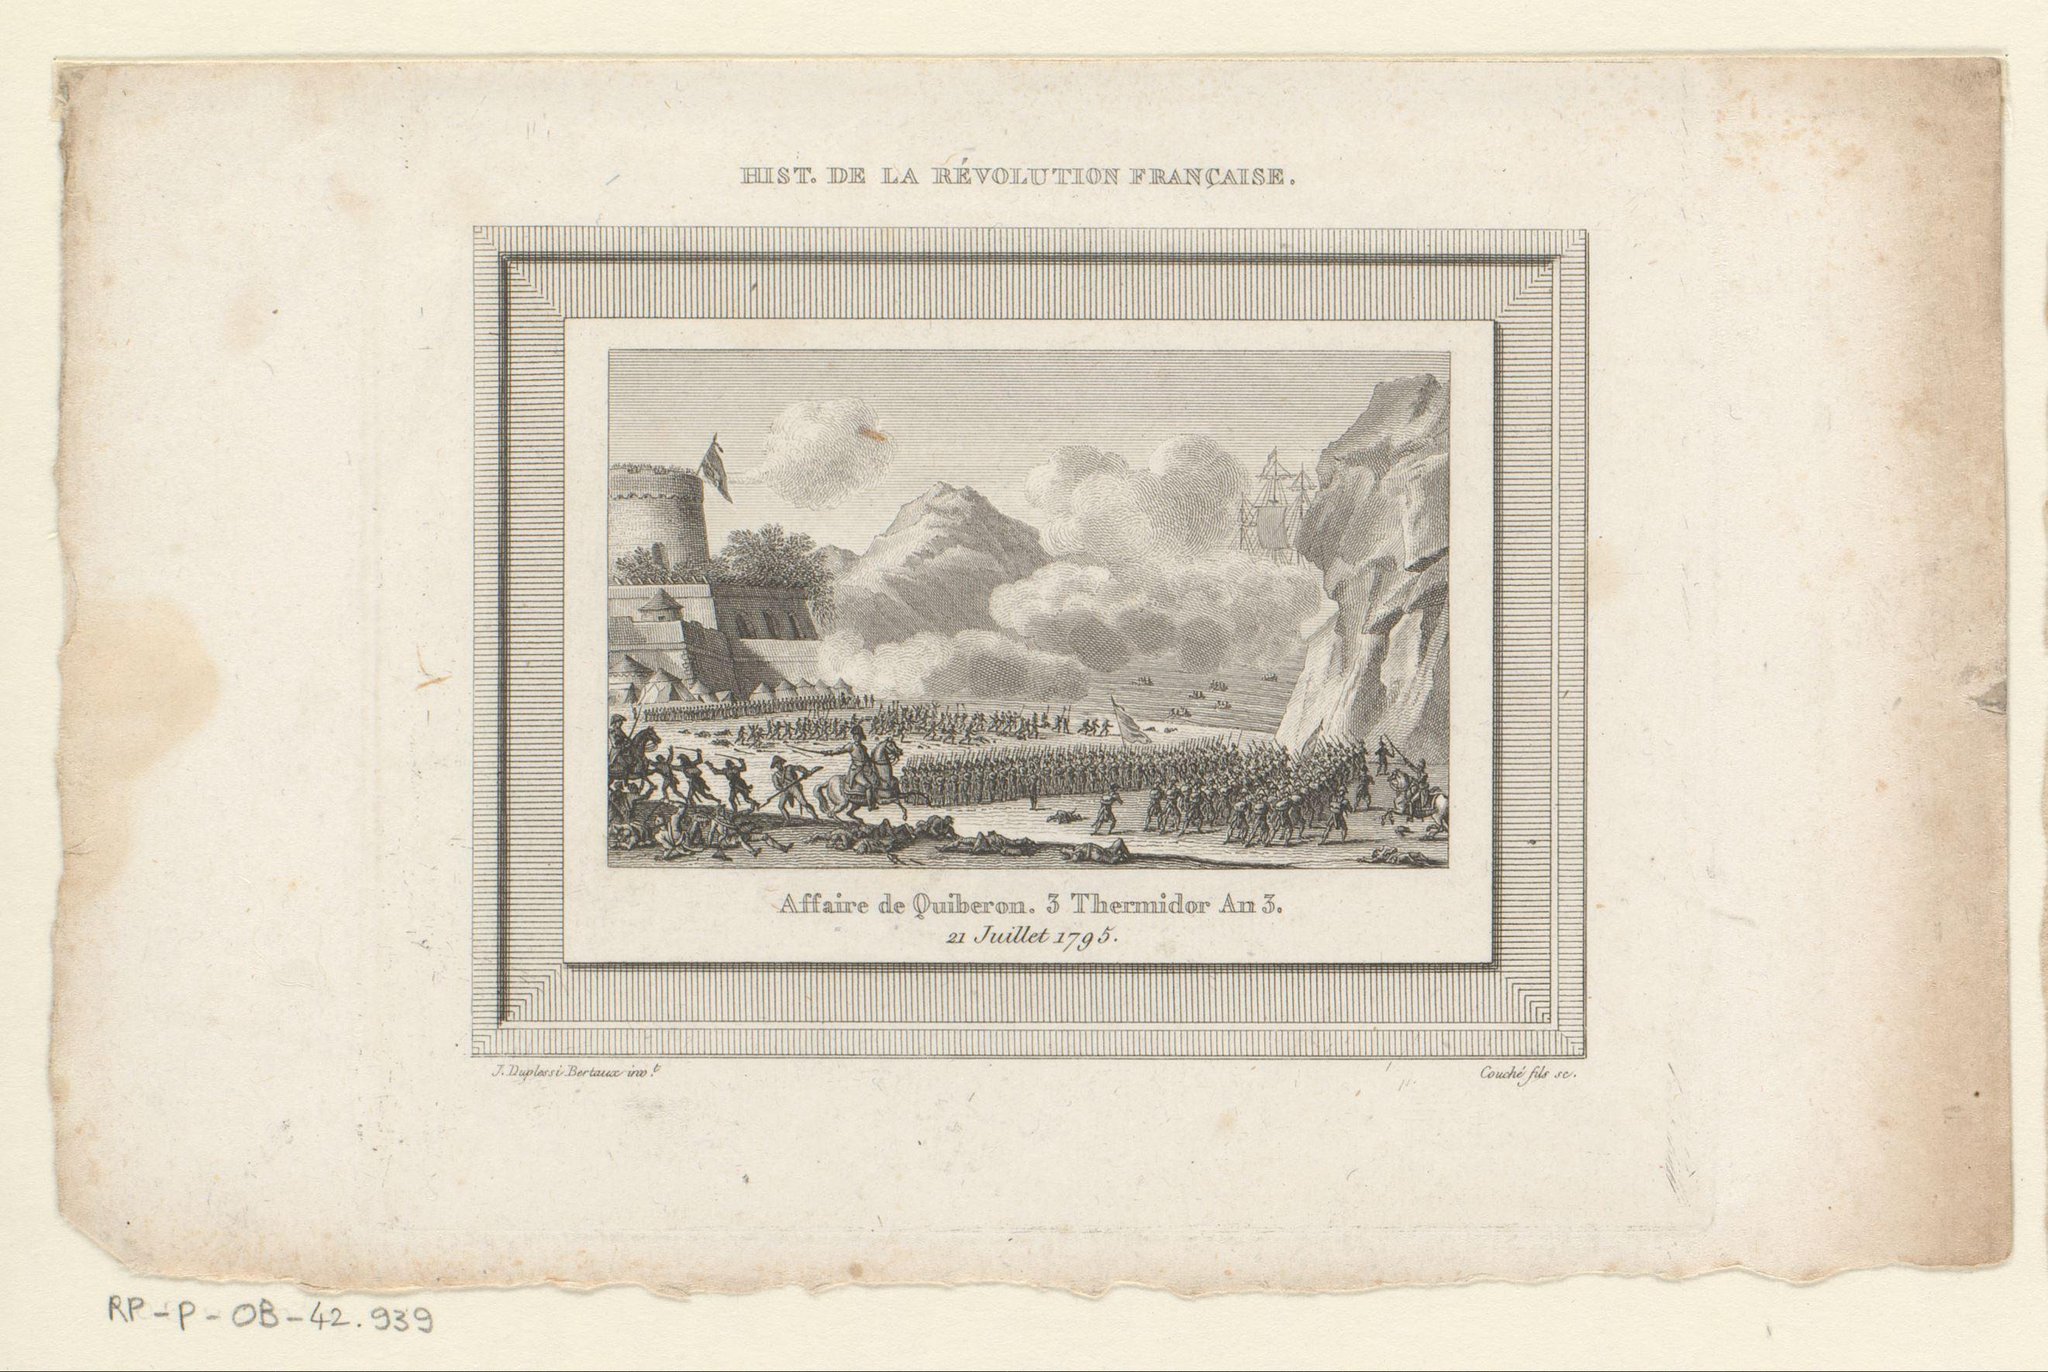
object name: print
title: Histoire de la Révolution Française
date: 1795-1849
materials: paper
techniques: etching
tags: battle, revolution, revolt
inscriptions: collector's mark: Lugt 2228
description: Maakt deel uit van een serie getiteld 'Histoire de la Révolution Française' met belangrijke gebeurtenissen uit de Franse Revolutie.